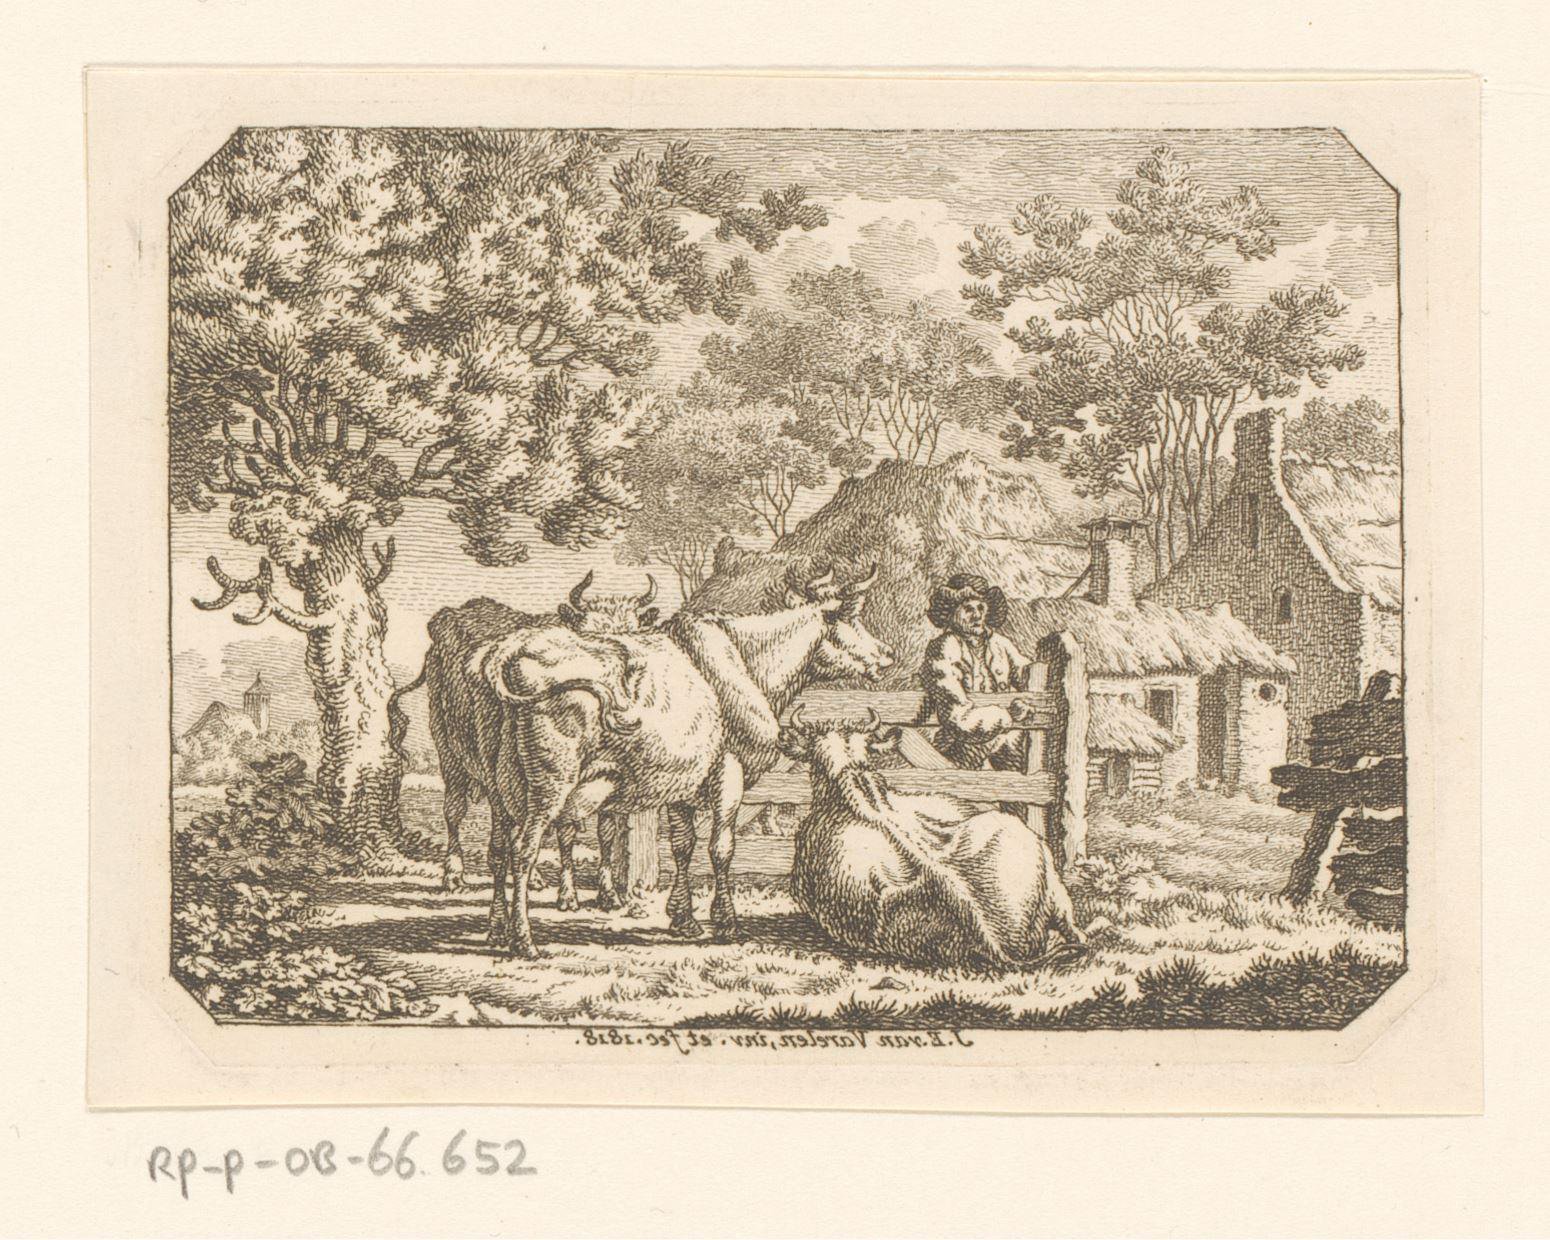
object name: print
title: Drie koeien bij een boer aan een hek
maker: jacob elias van varelen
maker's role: draughtsman, print maker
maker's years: 1757-1840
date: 1818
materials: paper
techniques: etching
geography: haarlem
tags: cow, farm or solitary house in landscape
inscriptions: collector's mark: Lugt 2228